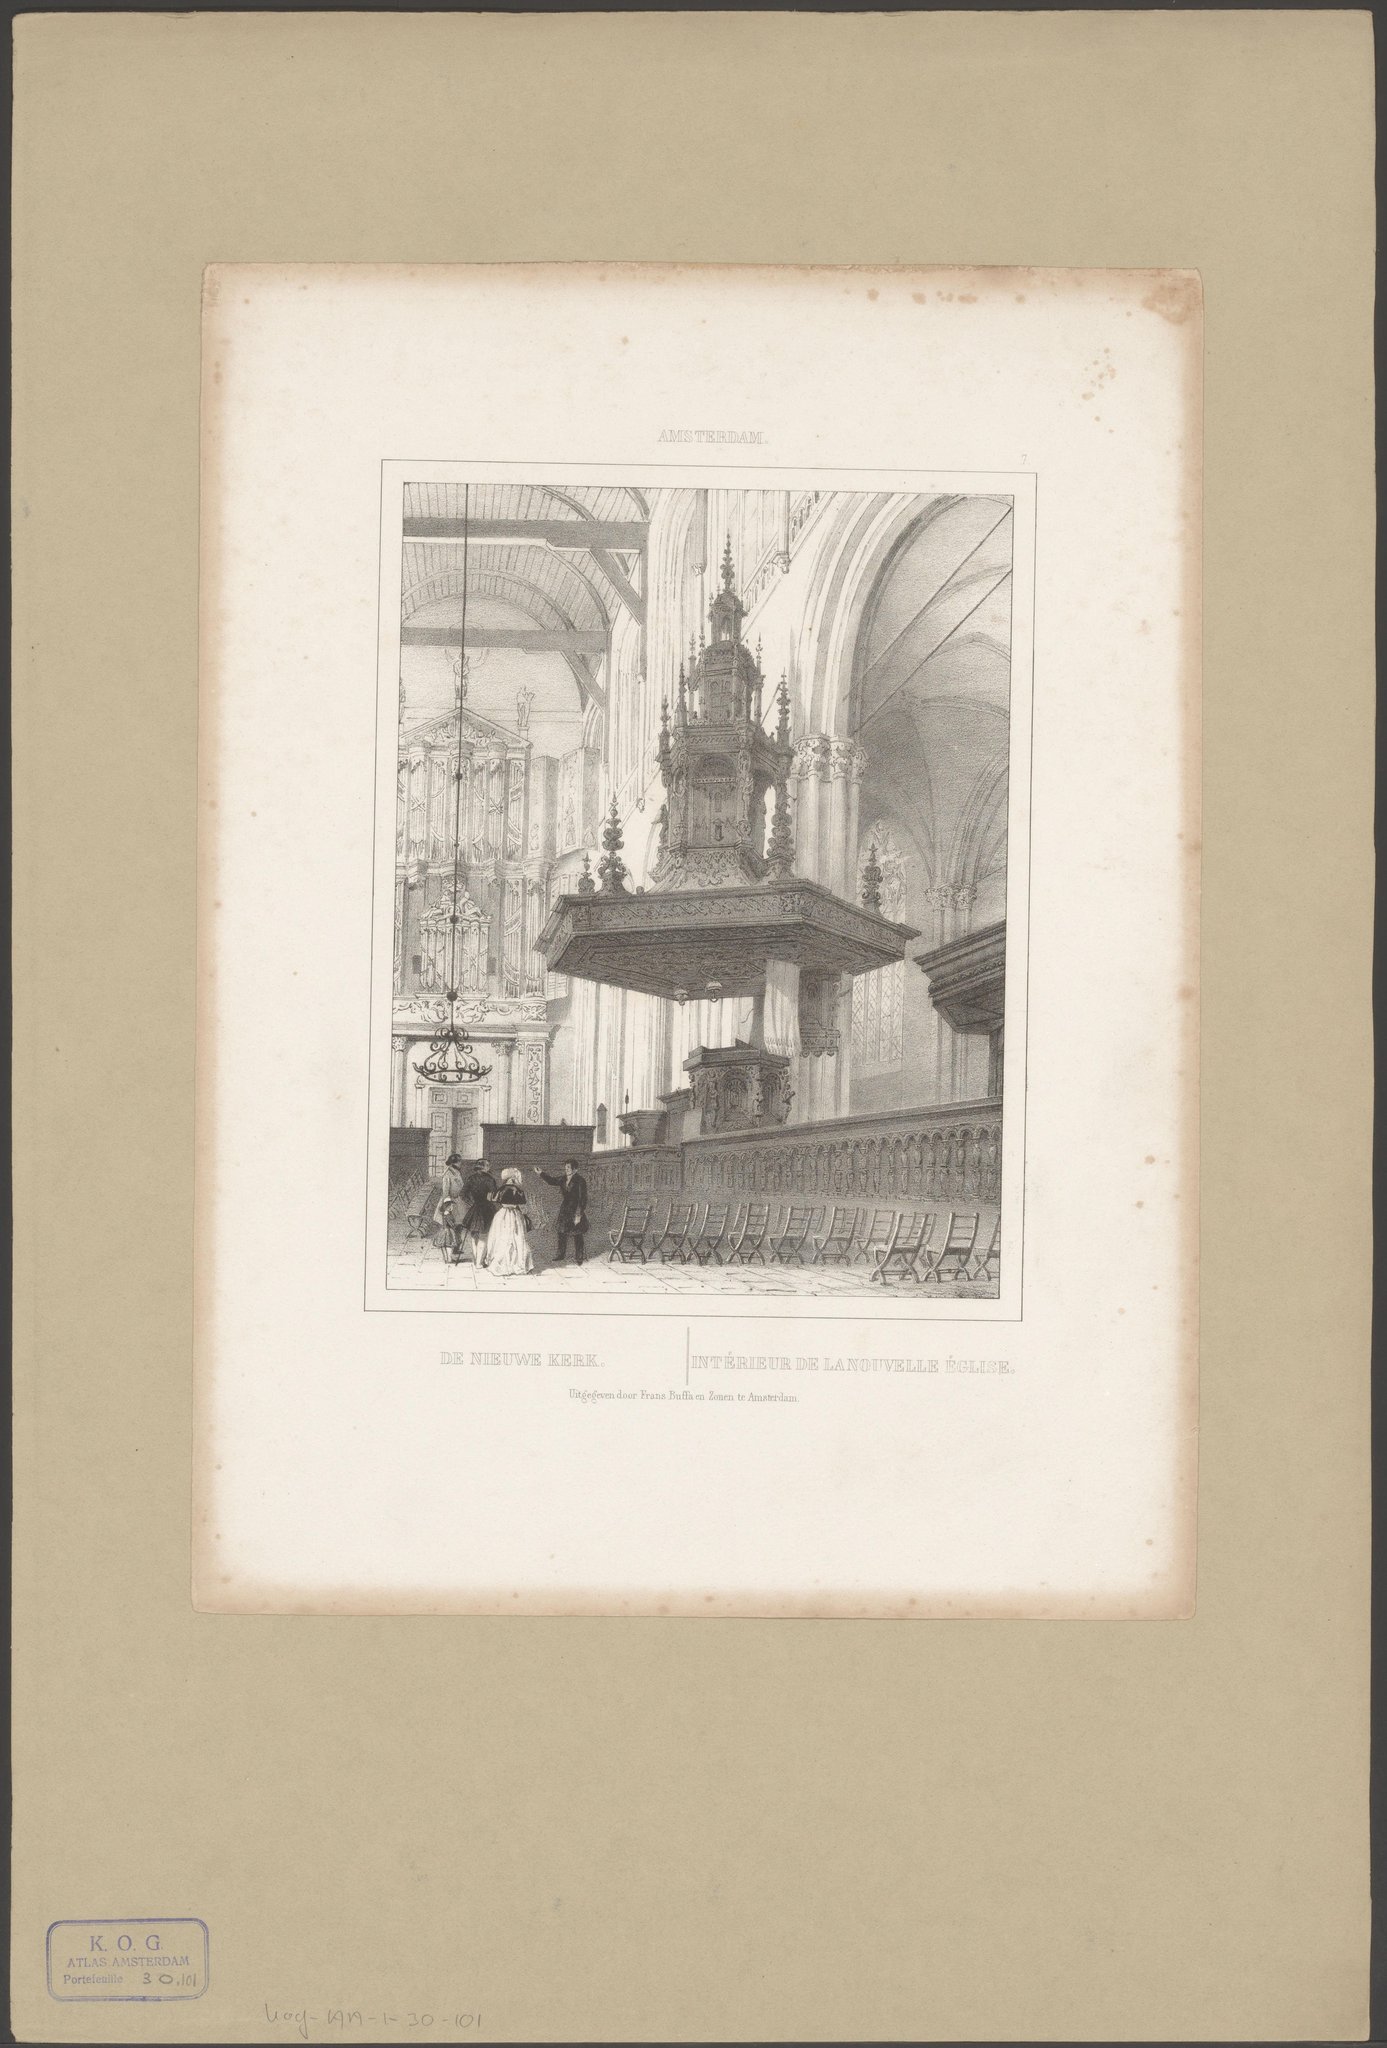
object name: print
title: Amsterdam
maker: Anonymous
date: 1836-1850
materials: paper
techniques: lithograph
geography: amsterdam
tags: interior of church, pulpit, ambo, chancel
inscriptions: collector's mark: Lugt 1641b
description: Rechtsboven genummerd: 7. Onderwerpsrubriek binnen de Atlas Amsterdam: Kerkwezen: Hervormde Gemeente: Nieuwe Kerk van binnen.